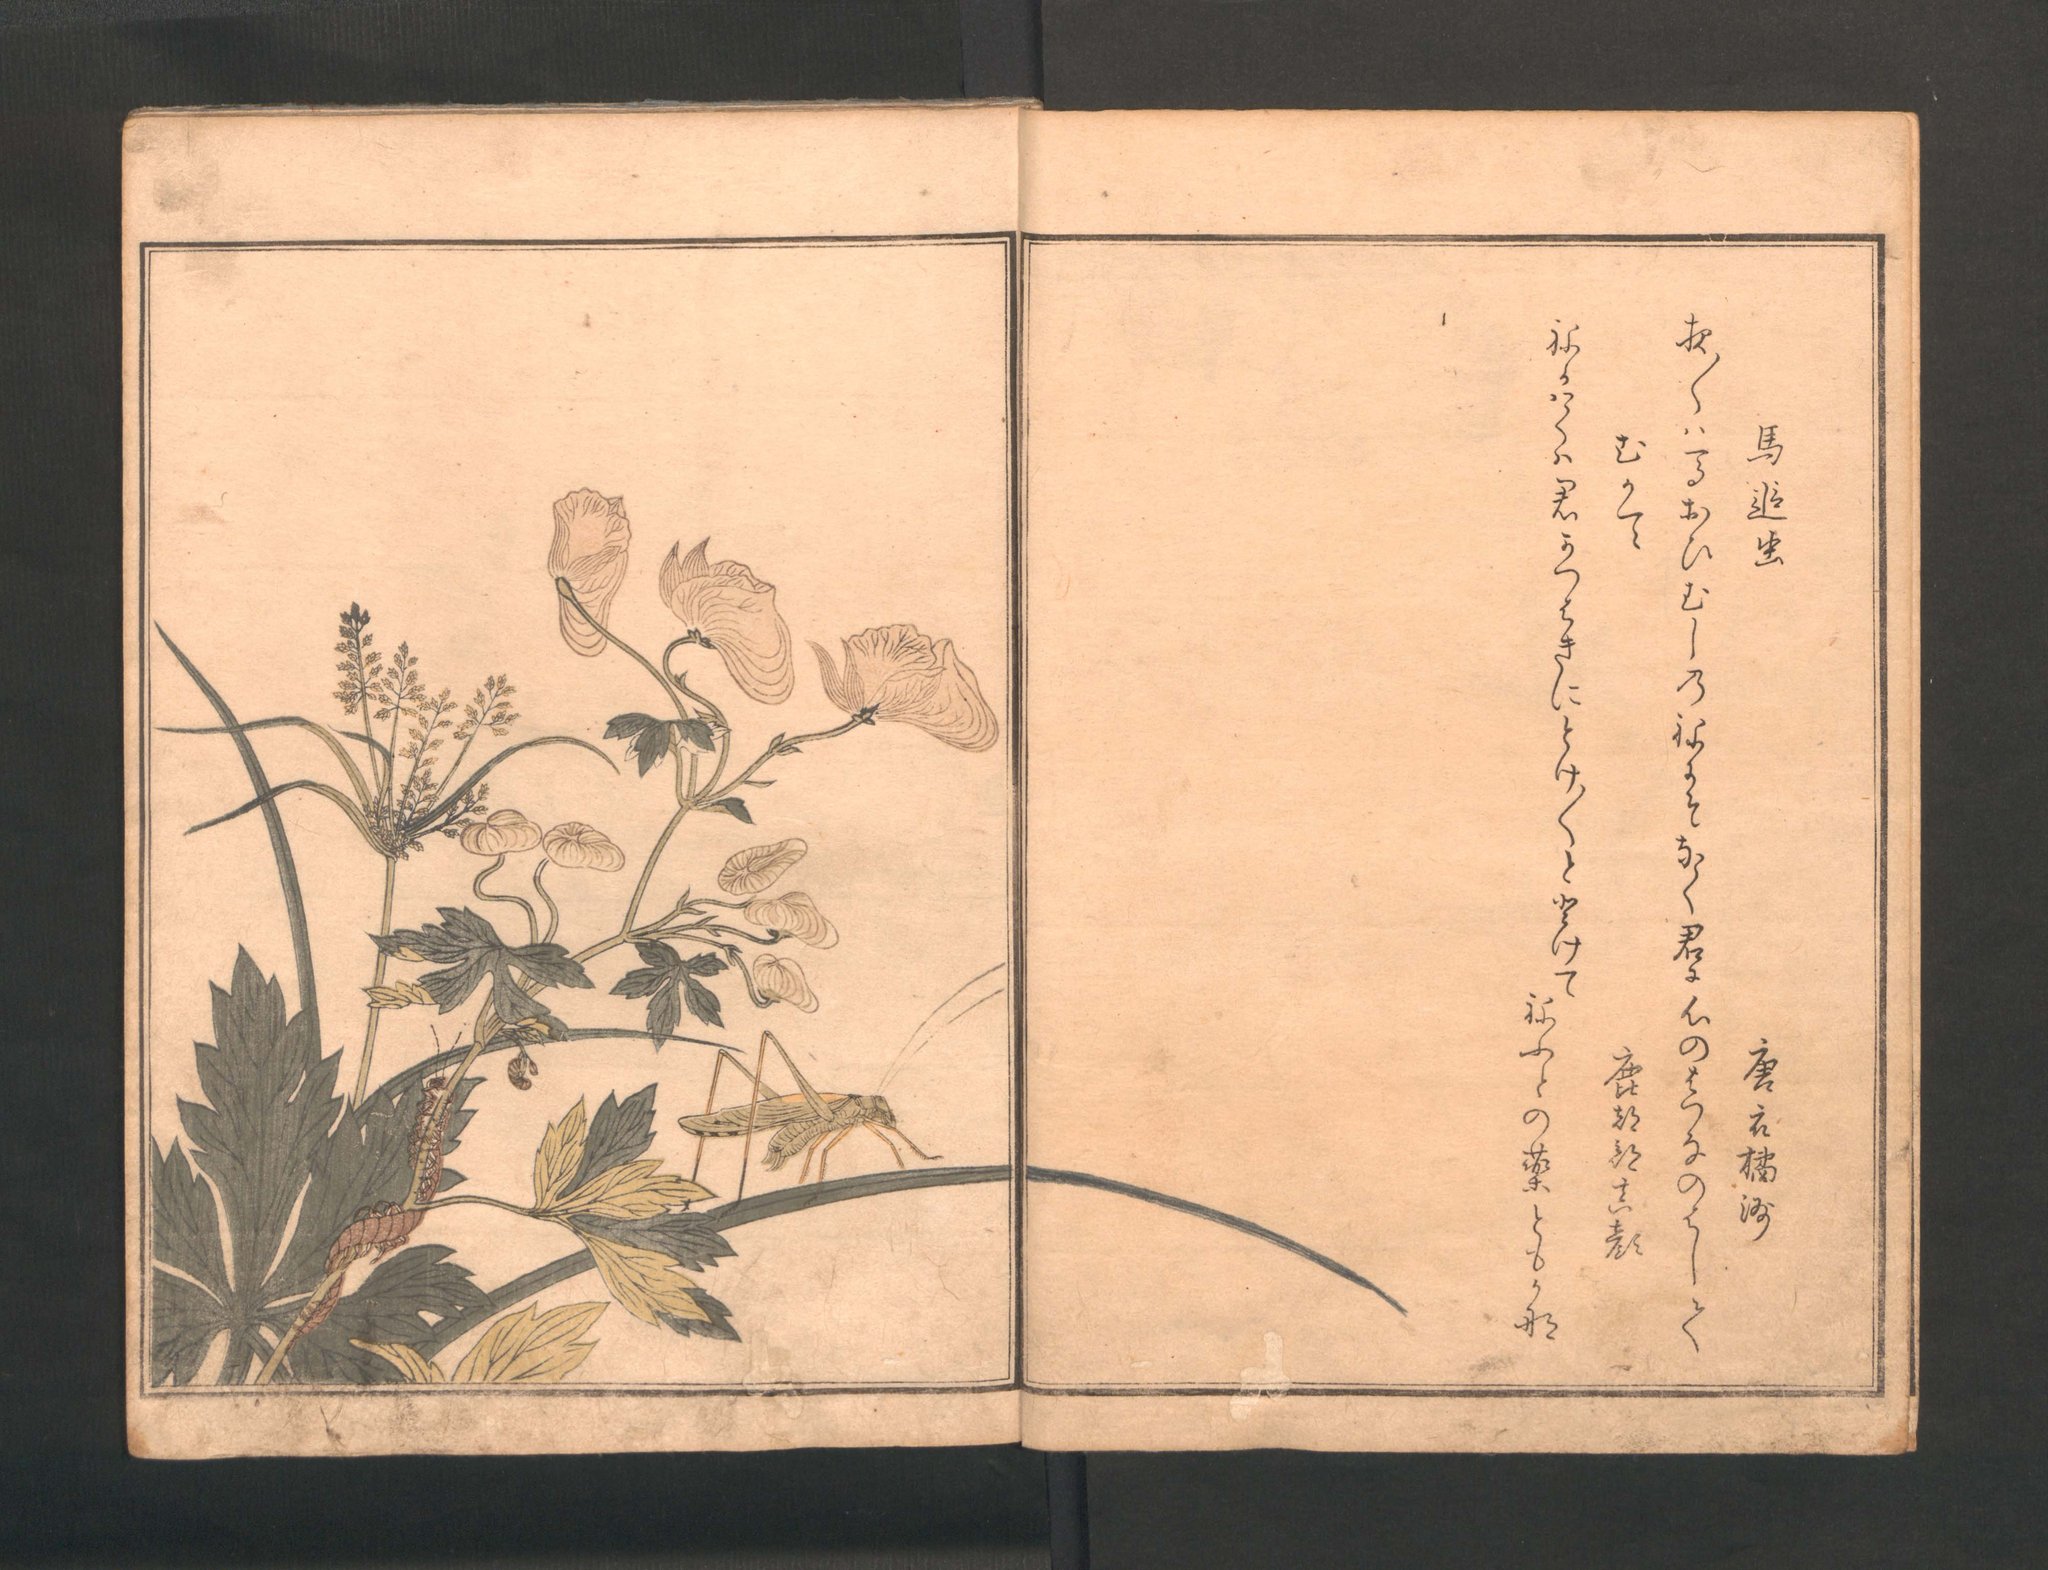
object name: illustrated book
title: Picture Book of Crawling Creatures (The Insect Book) (Ehon mushi erami) 画本虫撰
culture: japanese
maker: kitagawa utamaro 喜多川歌麿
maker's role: artist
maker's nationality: japanese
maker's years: 1754-1806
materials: ink, paper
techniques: polychrome, woodblock print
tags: insects,flowers